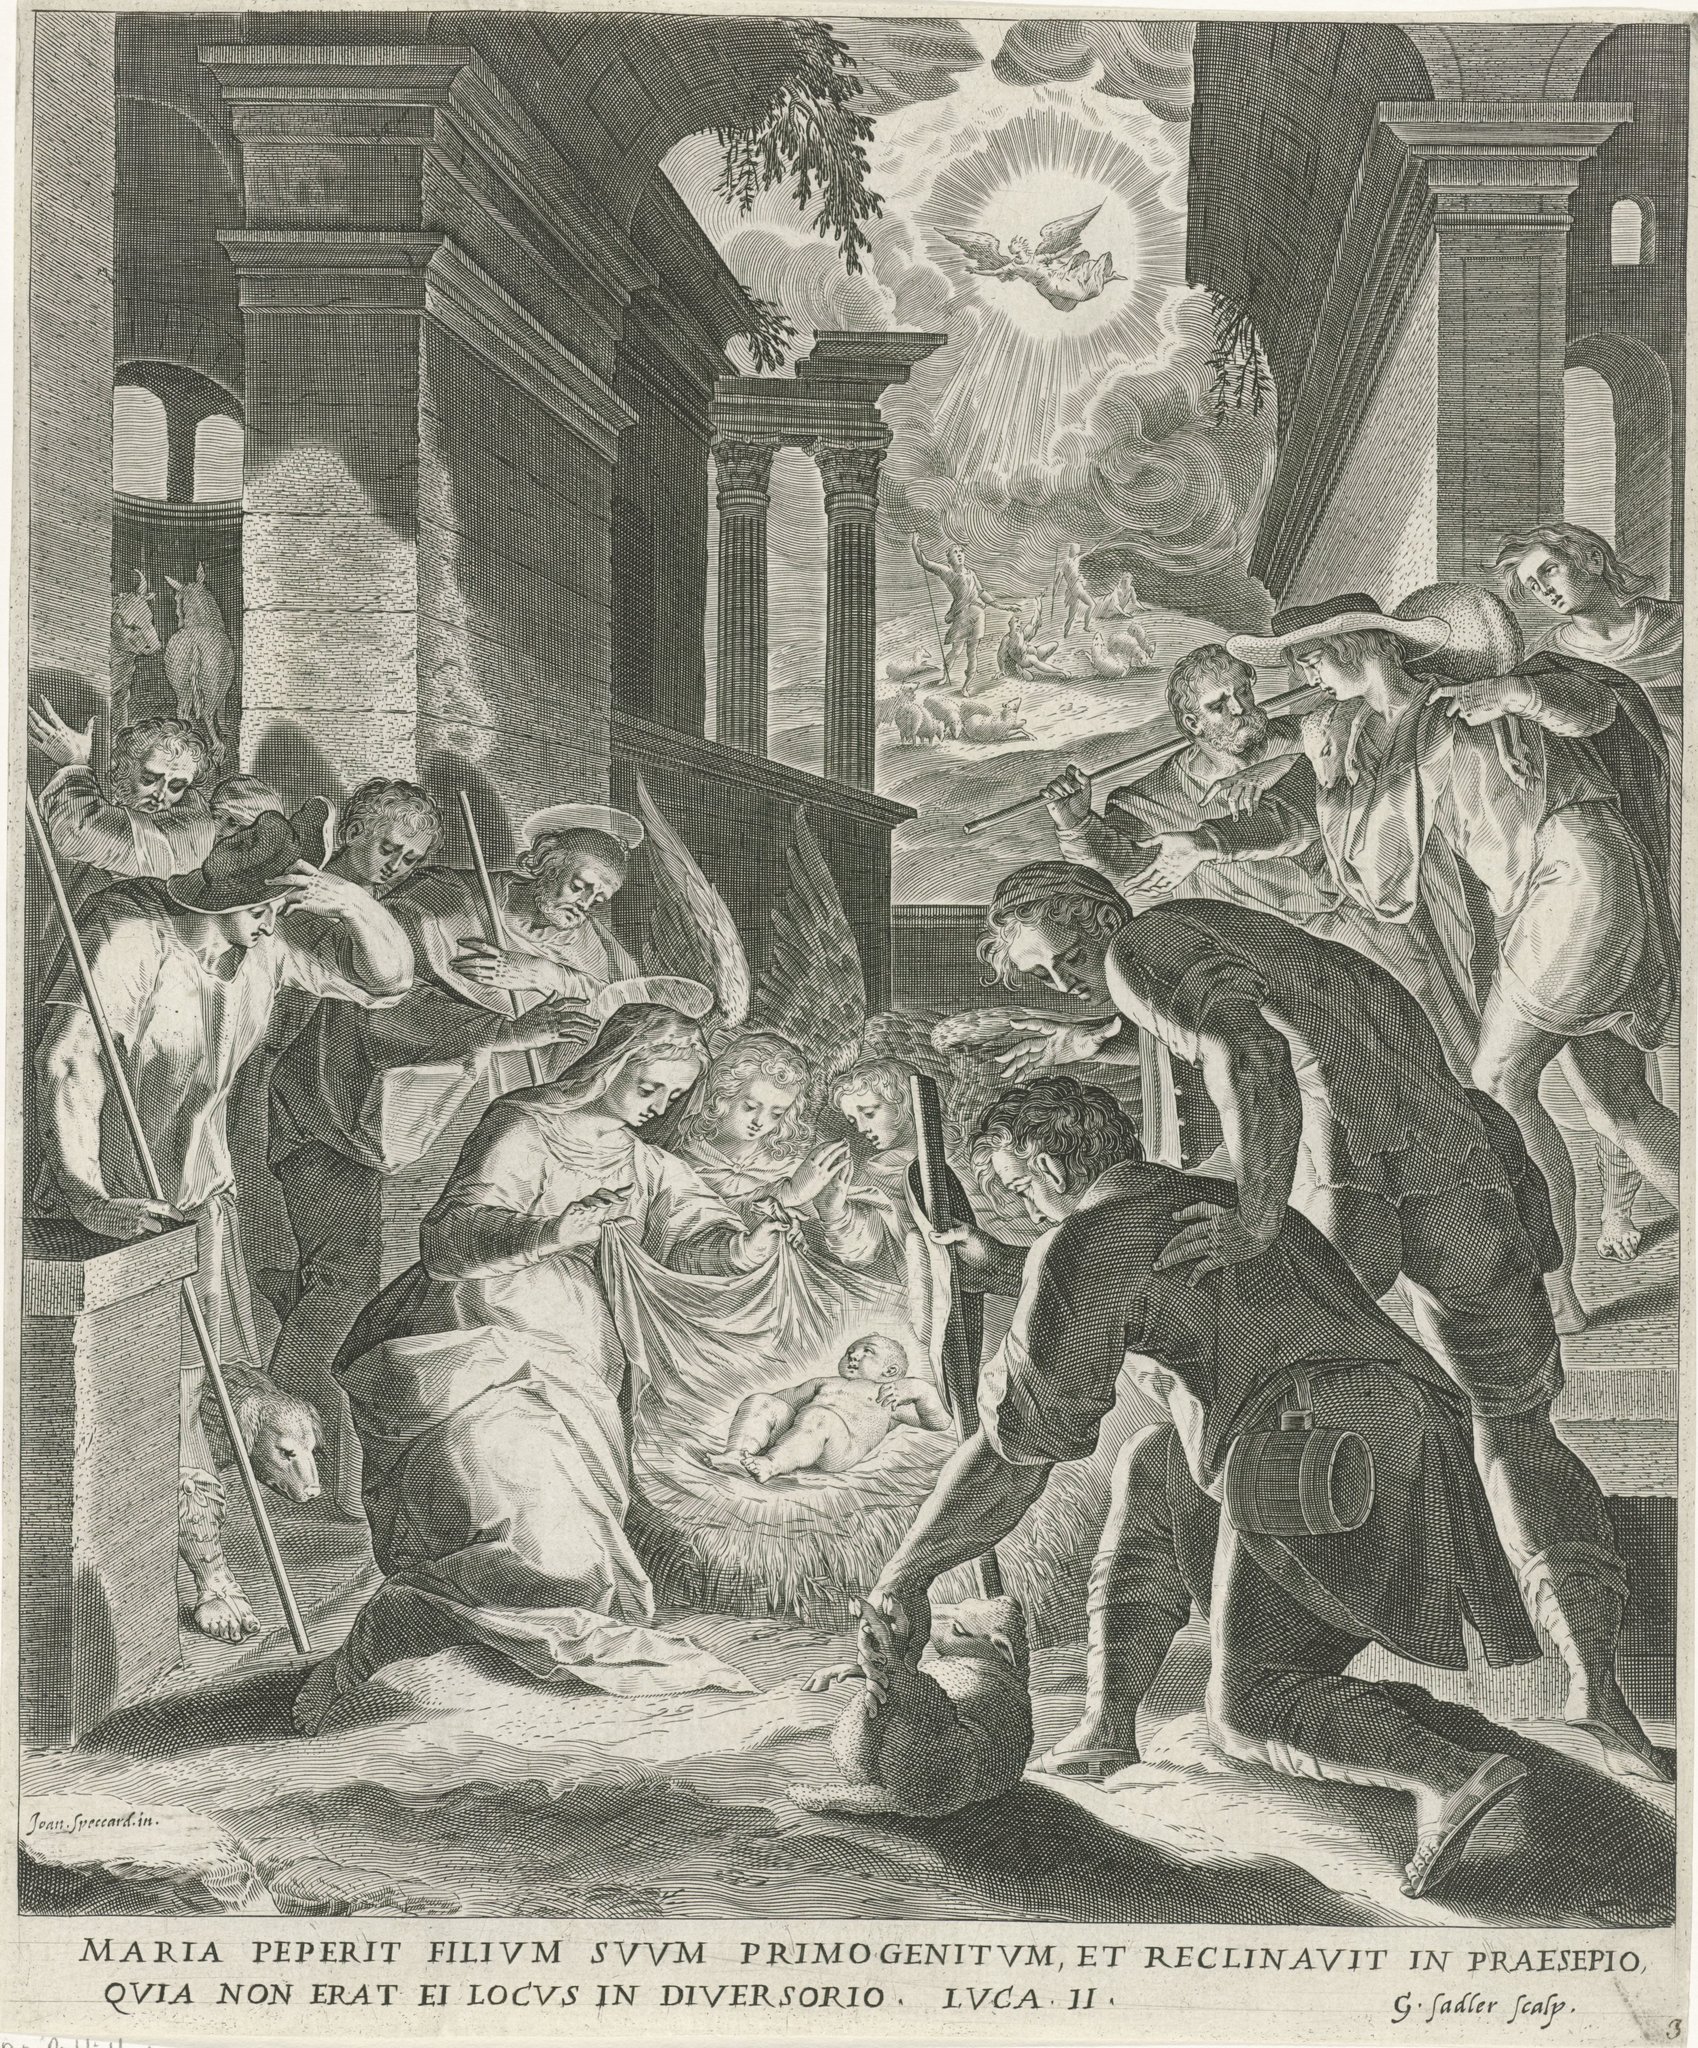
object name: print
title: Leven van Maria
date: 1580-1629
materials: paper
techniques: engraving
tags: adoration of the christ-child by the shepherds; mary and joseph present, annunciation of christ's birth to the shepherds (and/or shepherdesses) at night; a host of singing angels in the air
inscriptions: collector's mark: Lugt 11, number: ‘3’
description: De aanbidding door de herders (Lucas 2: 8-20). De herders scharen zich rondom het Christuskind, dat in een kribbe ligt. Maria zit naast het kind. Op de achtergrond de aankondiging van de geboorte van Christus aan de herders door de engel Gabriël. De prent heeft een Latijns onderschrift.